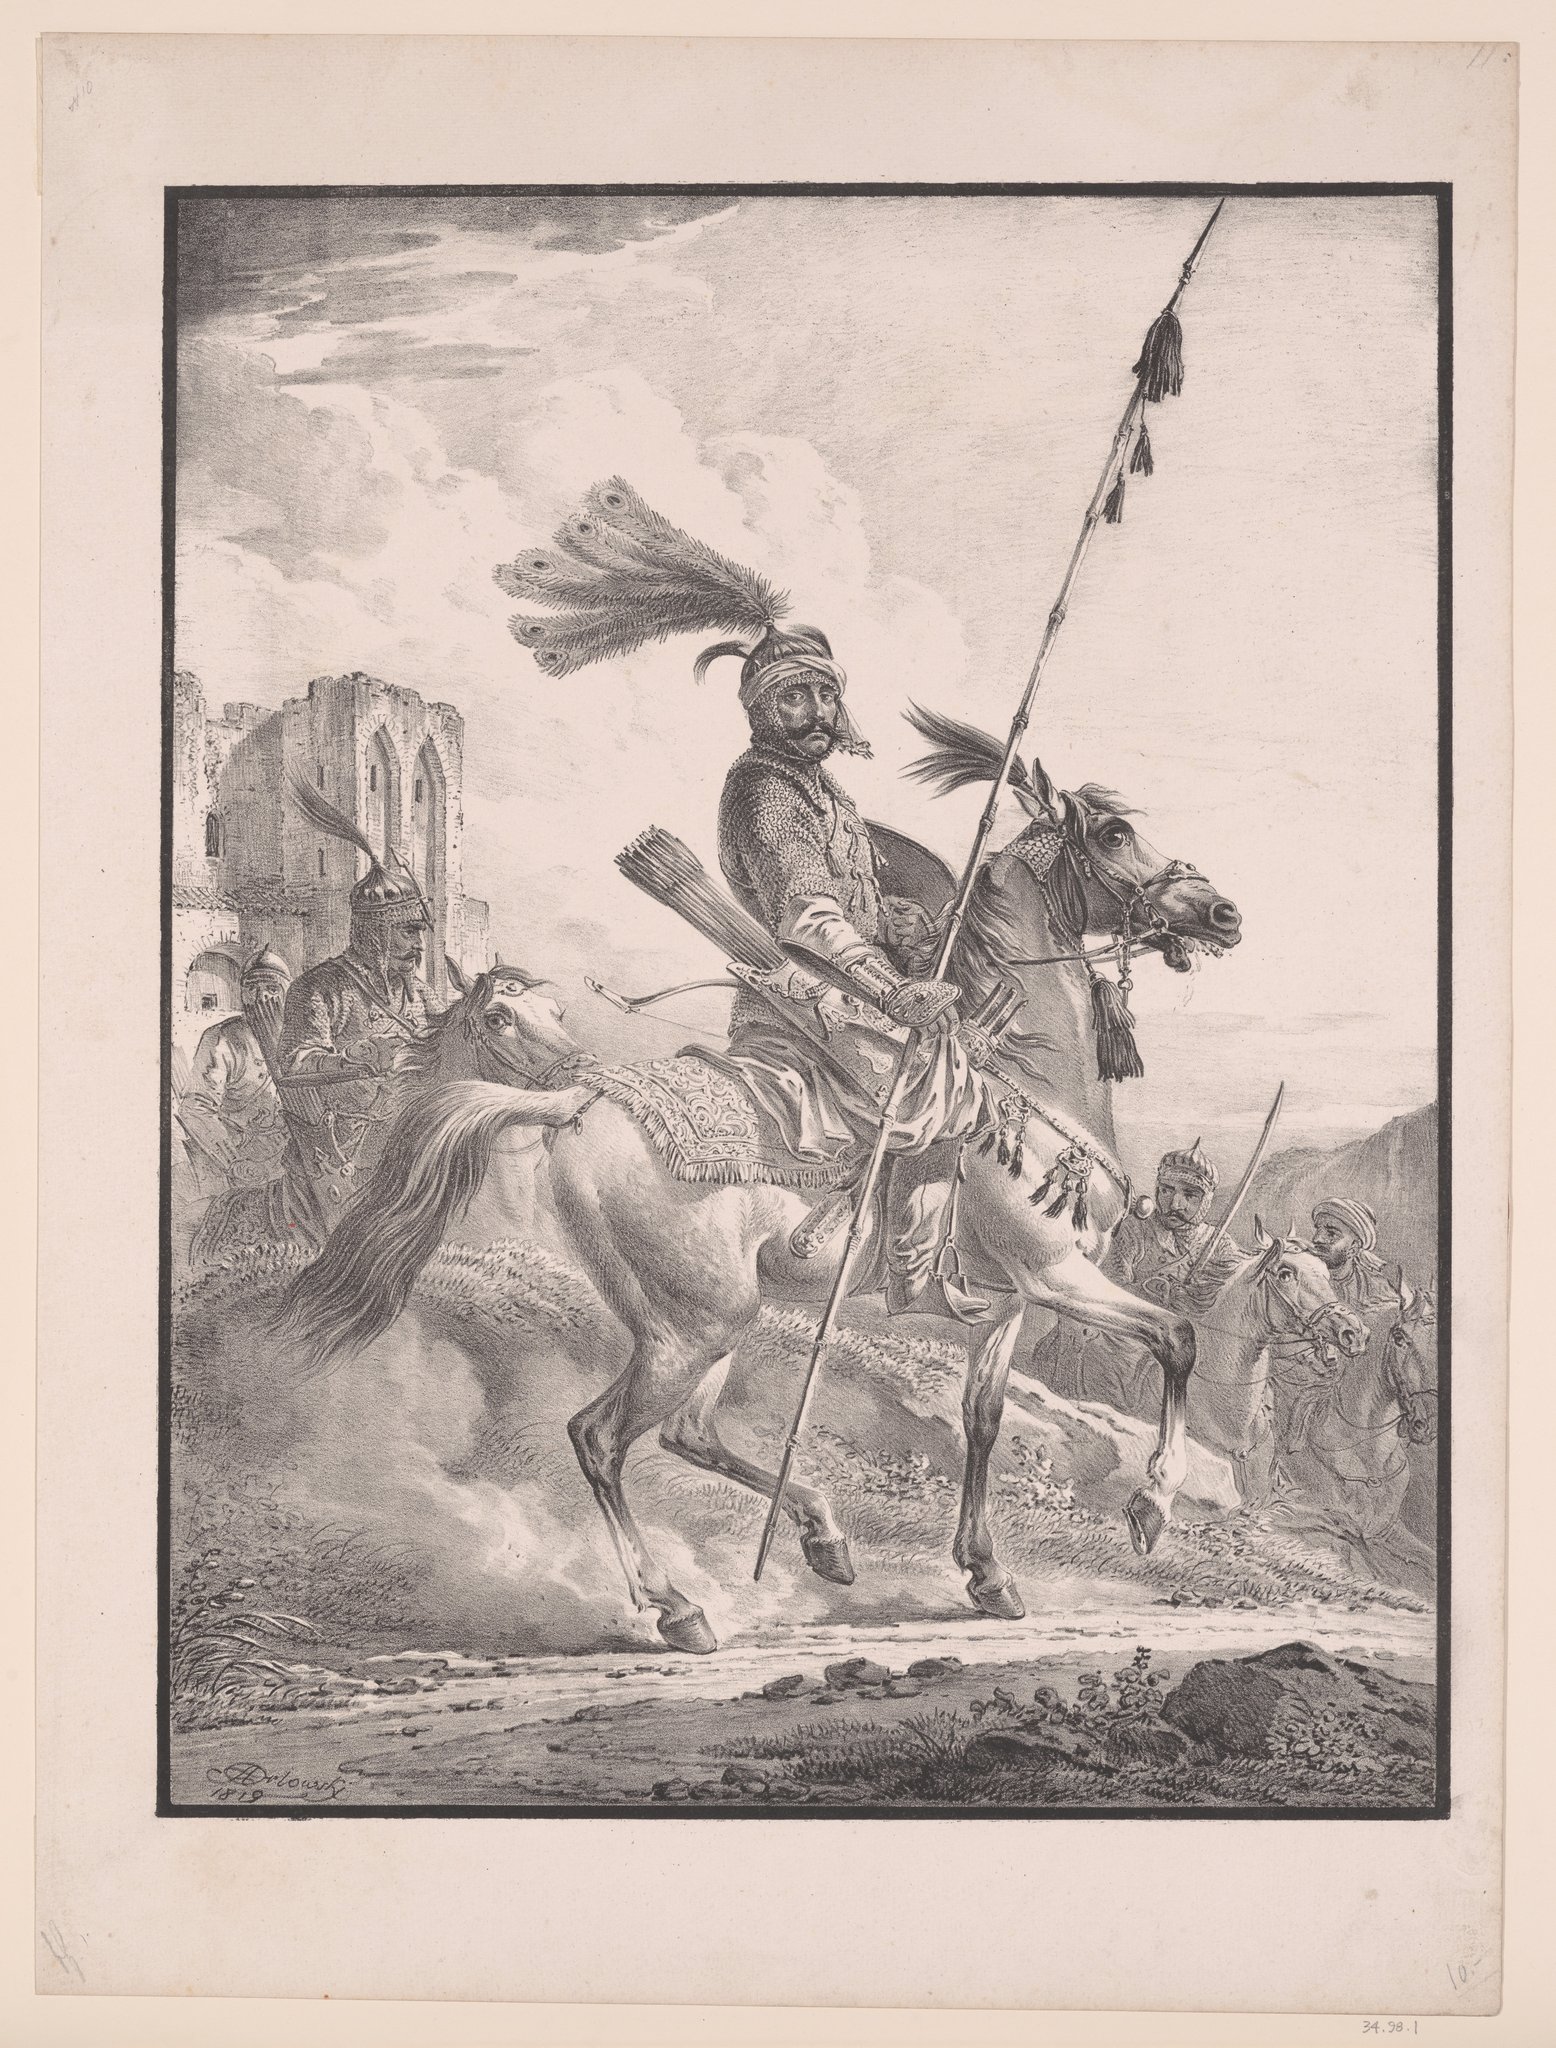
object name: print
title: Kurd in military armor on horseback, from "Collection de dessins litographiques par Alexandre Orlowski"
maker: aleksandr orlovsky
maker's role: artist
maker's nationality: russian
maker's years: 1777-1832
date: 1819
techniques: lithograph